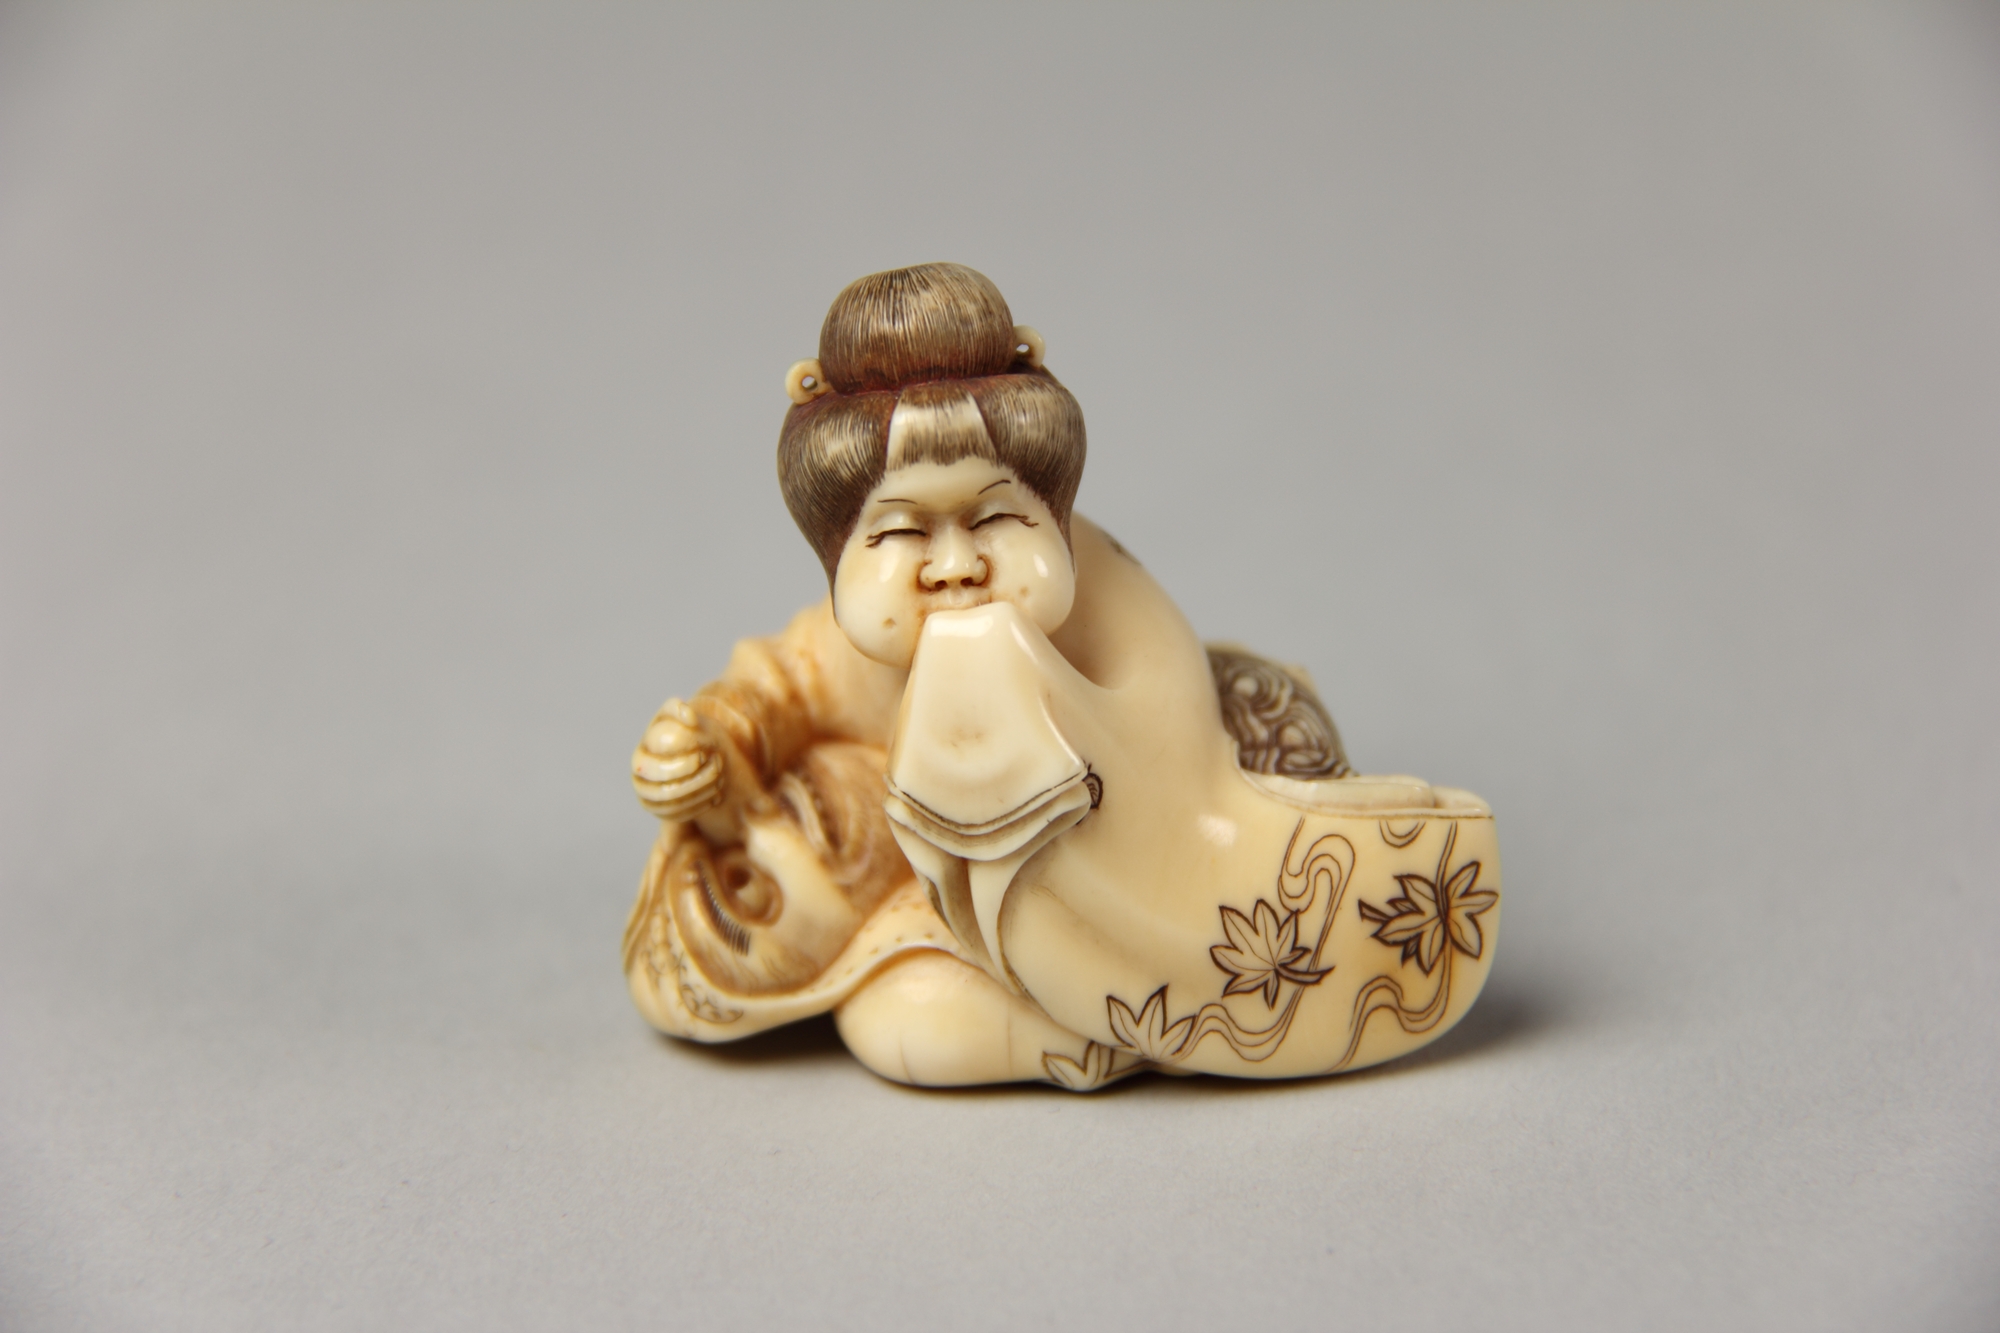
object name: netsuke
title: Seated Figure of Usume Laughing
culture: japanese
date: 1801-1900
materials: ivory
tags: human figures